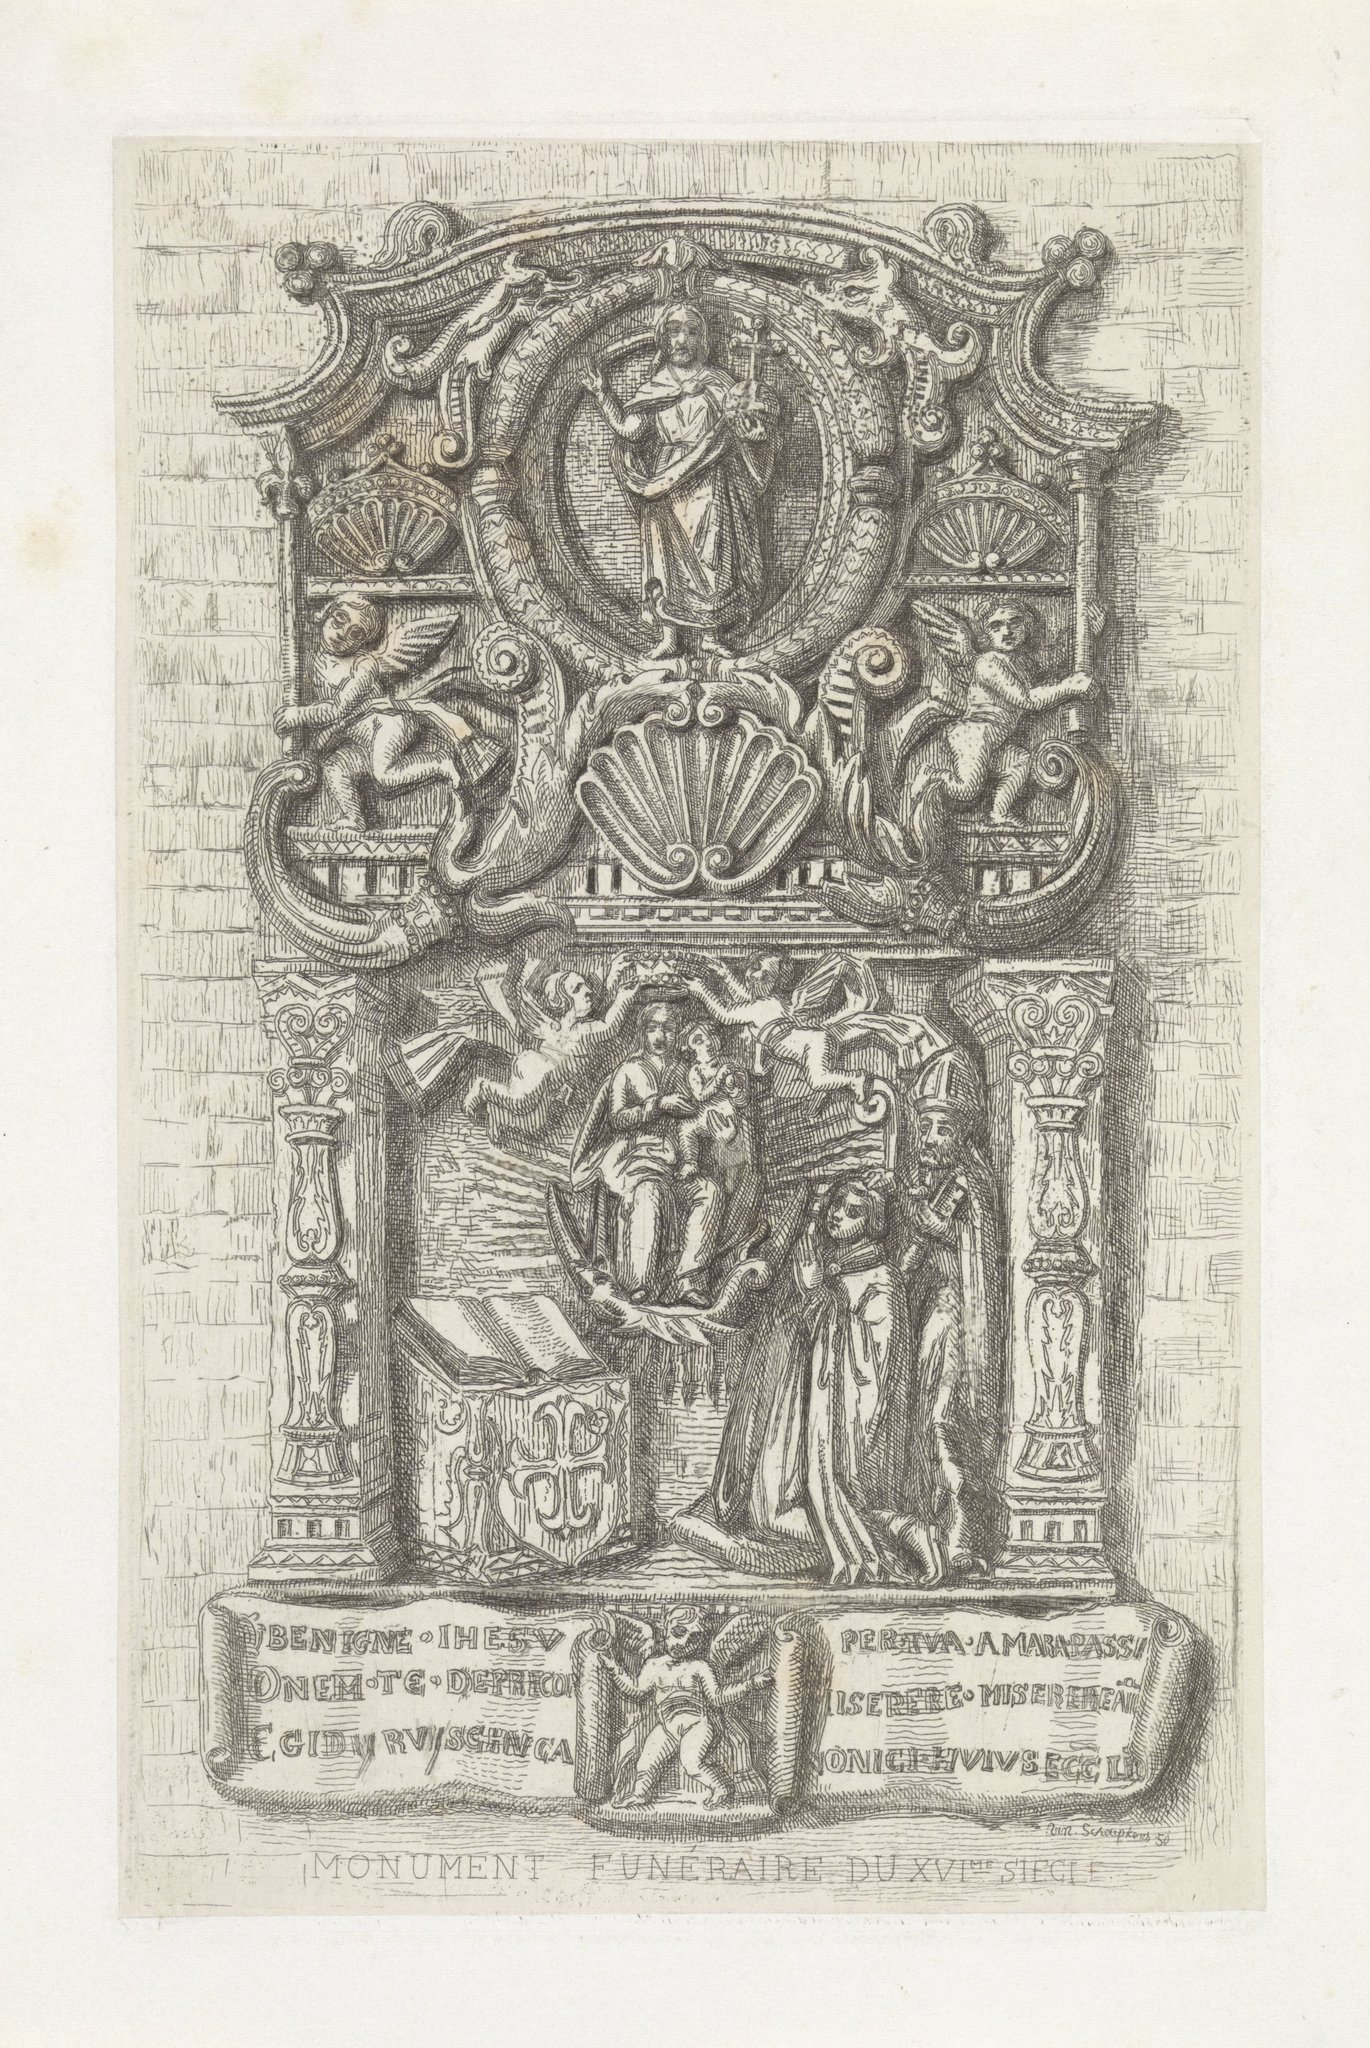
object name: print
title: Grafmonument met de kroning van Maria in reliëf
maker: arnoud schaepkens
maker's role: print maker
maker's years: 1816-1904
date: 1831-1904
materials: paper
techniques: drypoint, etching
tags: coronation of mary by one or more angels, grave, tomb and other grave-forms and grave-markers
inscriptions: collector's mark: Lugt 2228, collector's mark: Lugt 1485